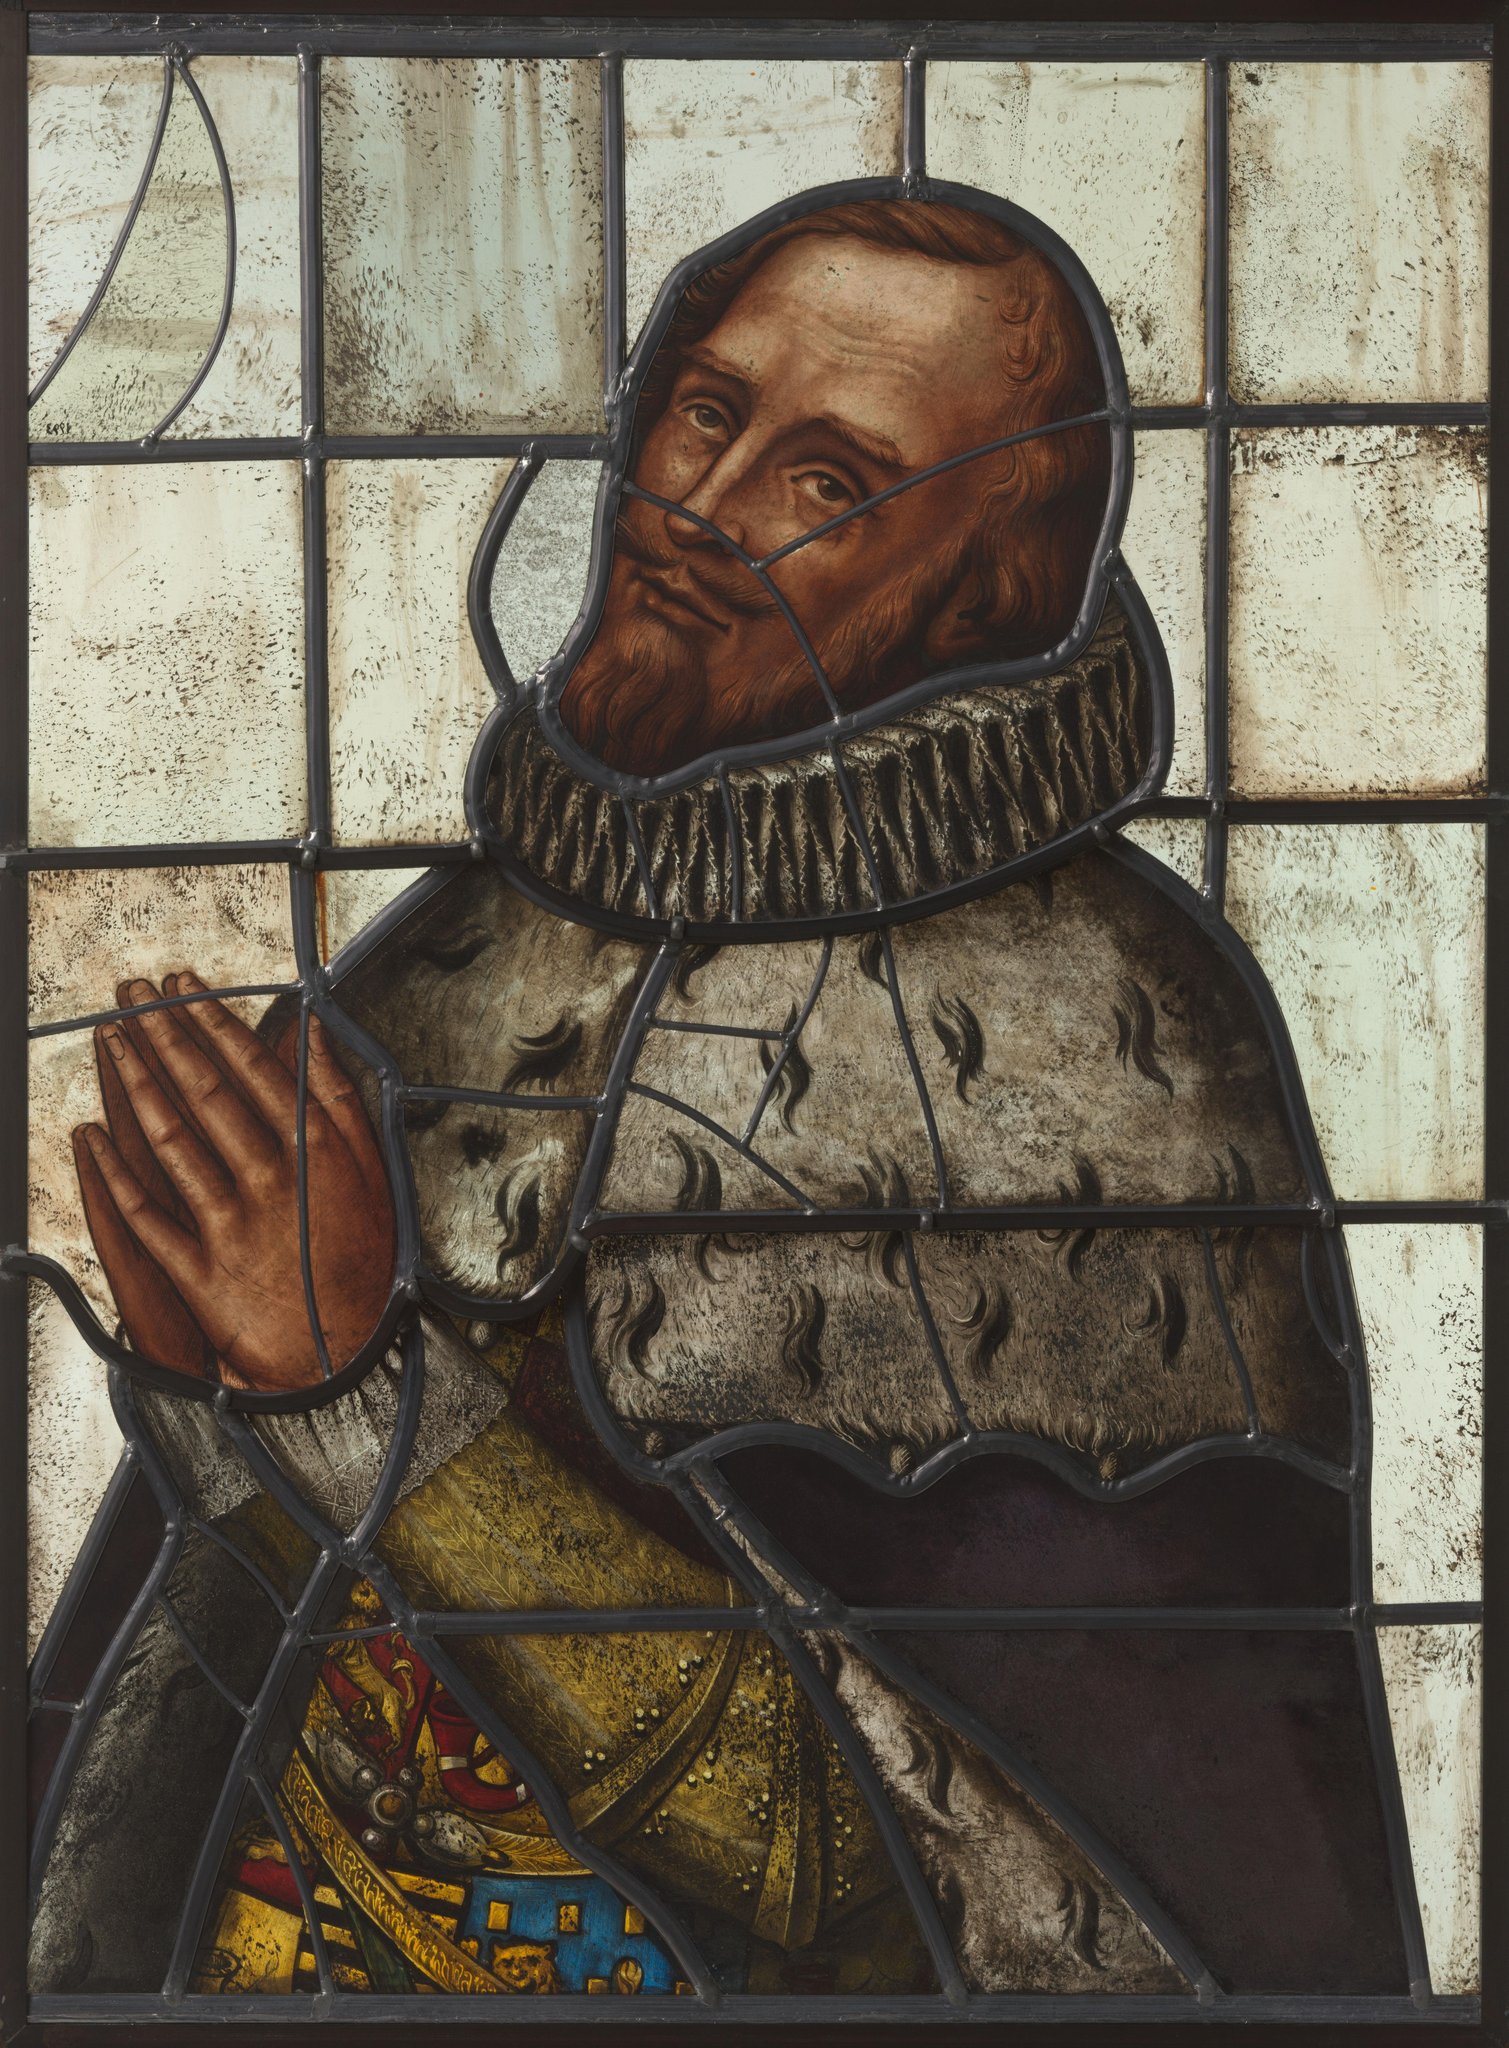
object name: light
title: Vijfde paneel van ruit met Prins Maurits in biddende houding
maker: Anonymous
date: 1618-1620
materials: glass, lead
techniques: leading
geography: netherlands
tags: the hague, maurice (prince of orange)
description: Groot raam afkomstig uit het klooster van St Agatha bij Cuyk. Prins Maurits in verguld harnas, met hermelijnen mantel en geplooide kraag, blootshoofds, in biddende houding, geknield op een bidstoel voor een lessenaar waarop een boek. De lessenaar staat op een tafel met een donkerblauw kleed met gouden franje gedekt. Helm en handschoenen liggen op de grond voor de tafel. De prins bevindt zich in een koepel door vier vrijstaande Korintische zuilen gedragen; boven zijn hoofd een baldakijn waaruit een lauwerkrans afhangt. De koepel wordt bekroond door het wapen van Maurits en het devies van de Orde van de Kousenband: 'Honi soit qui mal y pense' (Schande over hem die er kwaad van denkt). Wapen door twee lopende jongelingen gesteund. Het wapen leunt tegen het bovenstuk van de koepel. Onder dit tafereel bevinden zich brokstukken architectuur die onoordeelkundig zijn aangebracht. Rechts ligt een jonge vrouw geknield met opgeheven handen. Zij draagt een geel zijden mantel met hermelijn omzoomd. Het gezicht is in olieverf bijgemaakt in 1891.